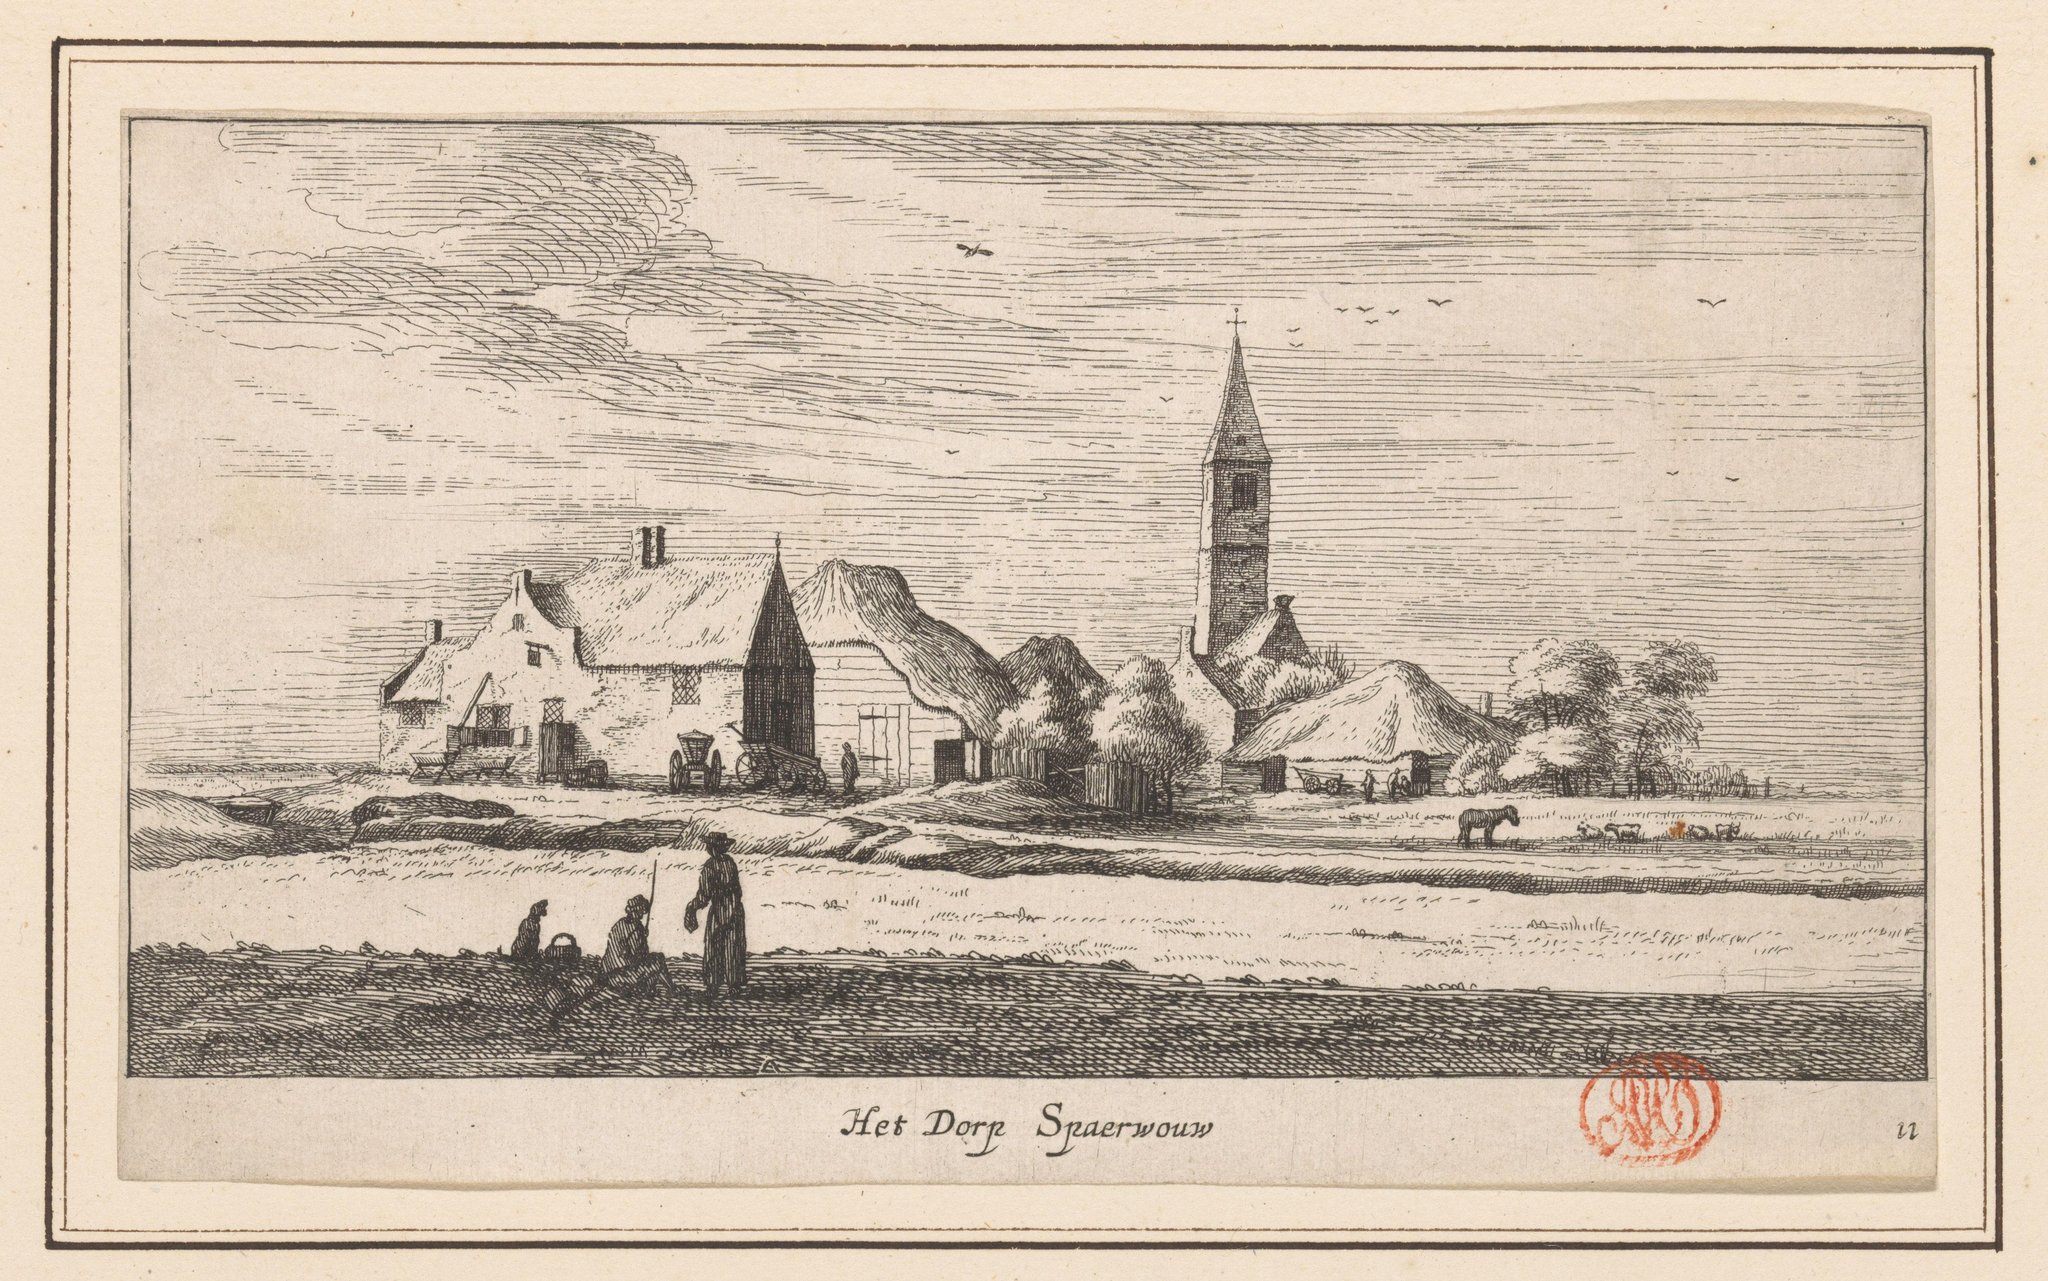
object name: print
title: Het dorp Spaerwouw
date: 1637-1652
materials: paper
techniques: engraving, etching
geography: amsterdam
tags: prospect of village, silhouette of village, church (exterior)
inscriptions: collector's mark: Lugt 195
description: Deze prent is onderdeel van een serie van dertien landschappen met dorpen rondom Amsterdam, gemaakt door Geertruydt Roghman naar tekeningen van haar broer Roelant Roghman.